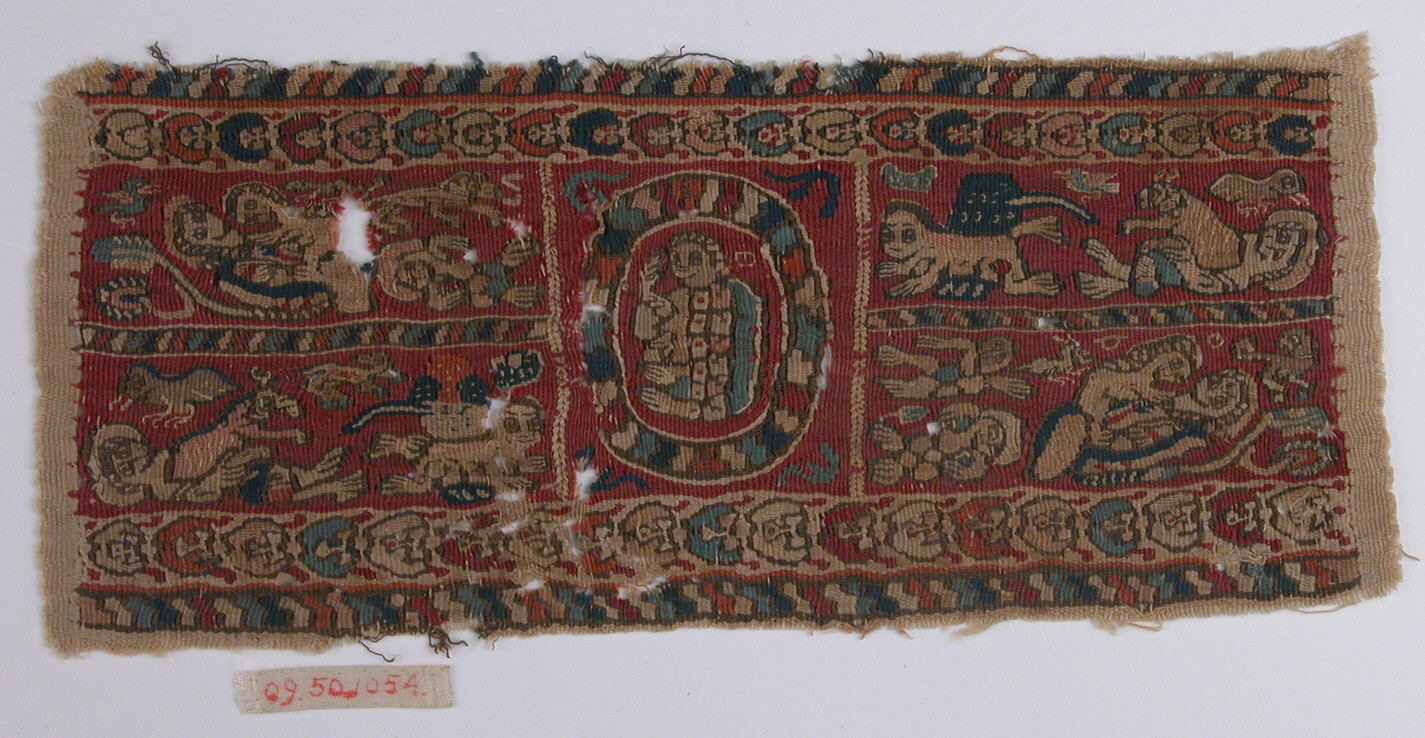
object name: band fragment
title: Fragment of a Band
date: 501-700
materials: wool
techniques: weave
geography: egypt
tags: mythical creatures